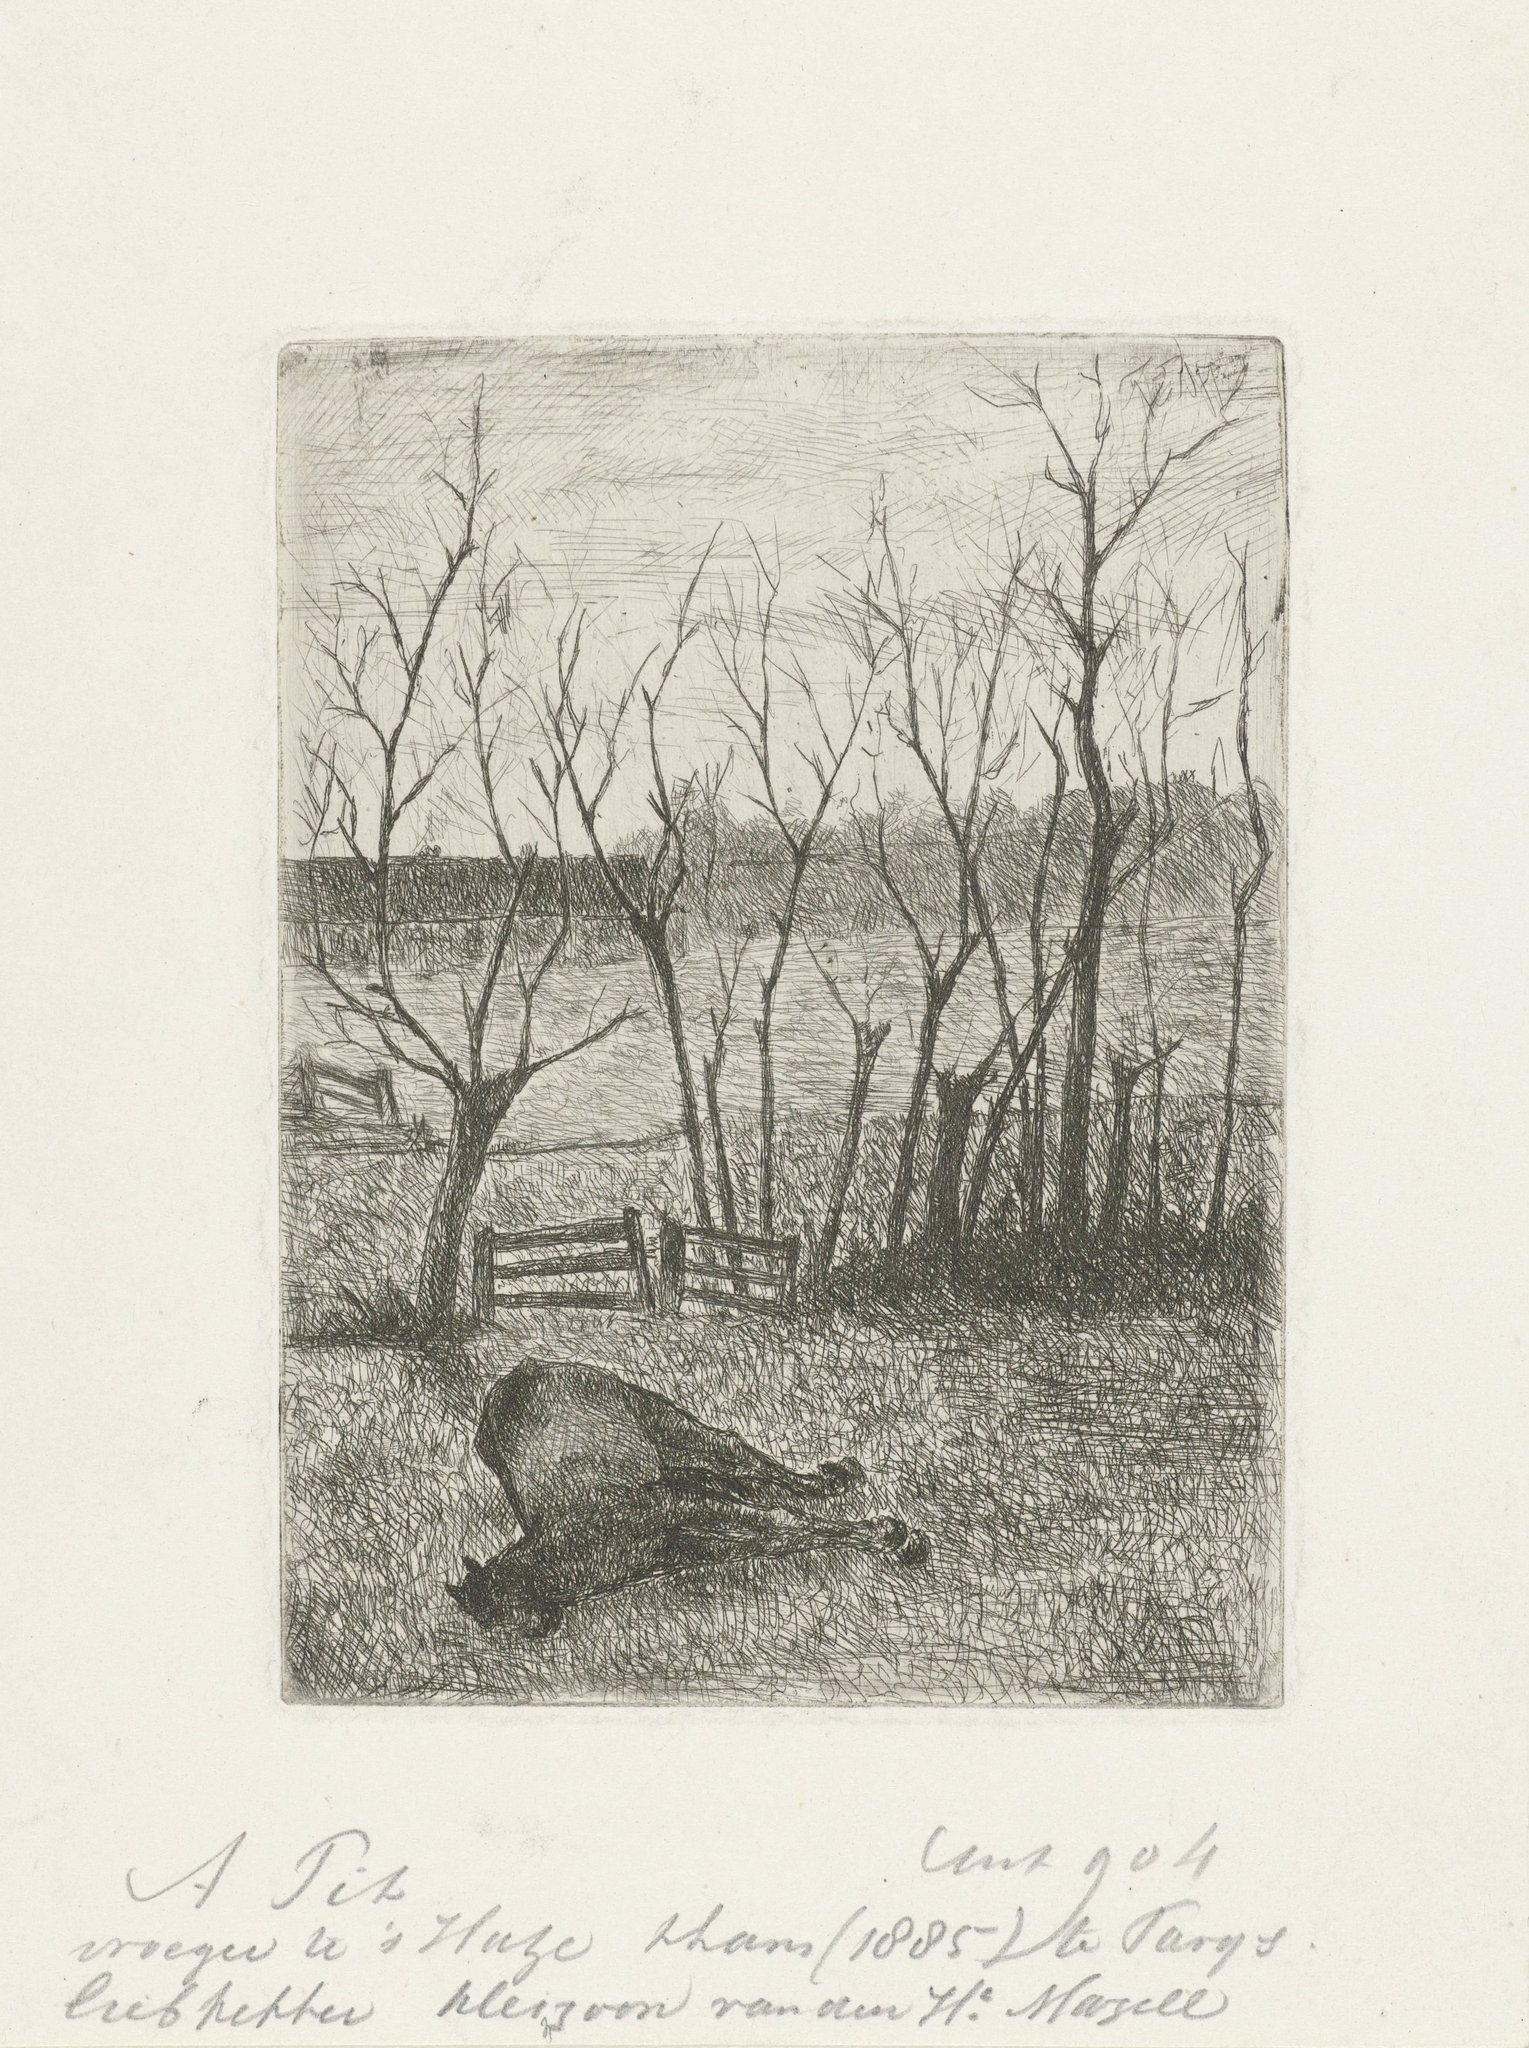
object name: print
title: Weiland met paard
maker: adriaan pit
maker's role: print maker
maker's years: 1860-1944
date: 1870-1887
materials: paper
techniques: etching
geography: netherlands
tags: horses and kindred animals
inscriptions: inscription: ‘Deze [...] door S. van Witsen te 's Hage gegeven.’, collector's mark: Lugt 2228, inscription: ‘A. Pit vroeger te 's Hage thans (1885) te Parijs liefhebbend kleinzoon van den Hr. Masell’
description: Een paard ligt op het gras in een weiland. Op de achtergrond een rij bomen en een houten hek als omheining.